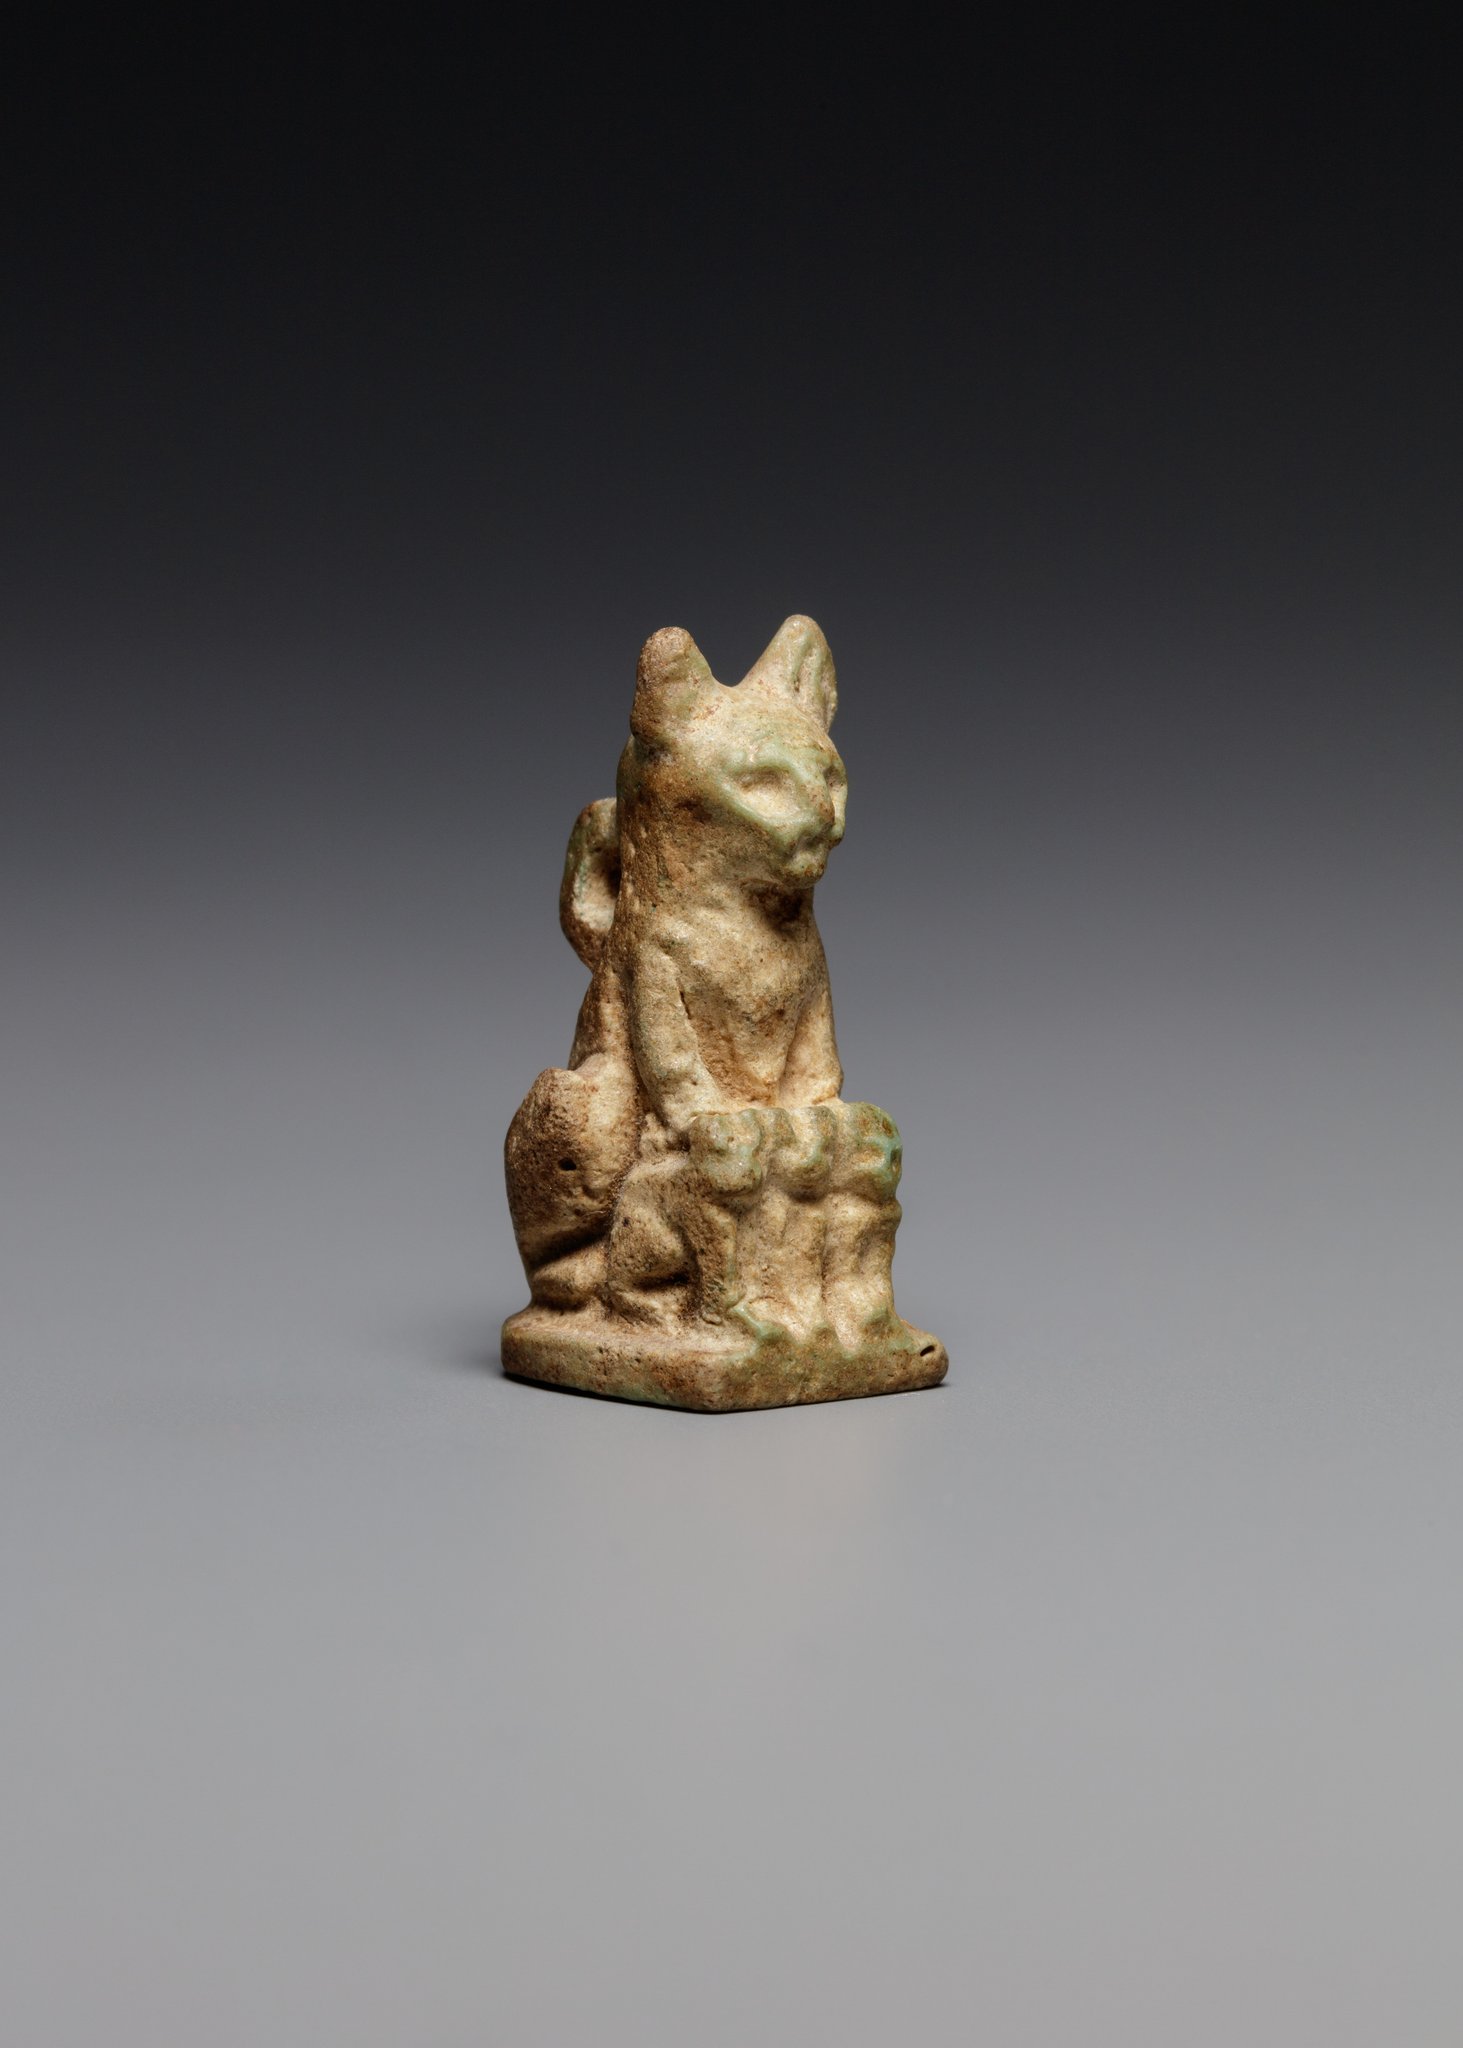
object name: amulet, cat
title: Amulet: Cat with 3 Kittens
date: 664-332 BCE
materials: faience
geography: egypt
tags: cats